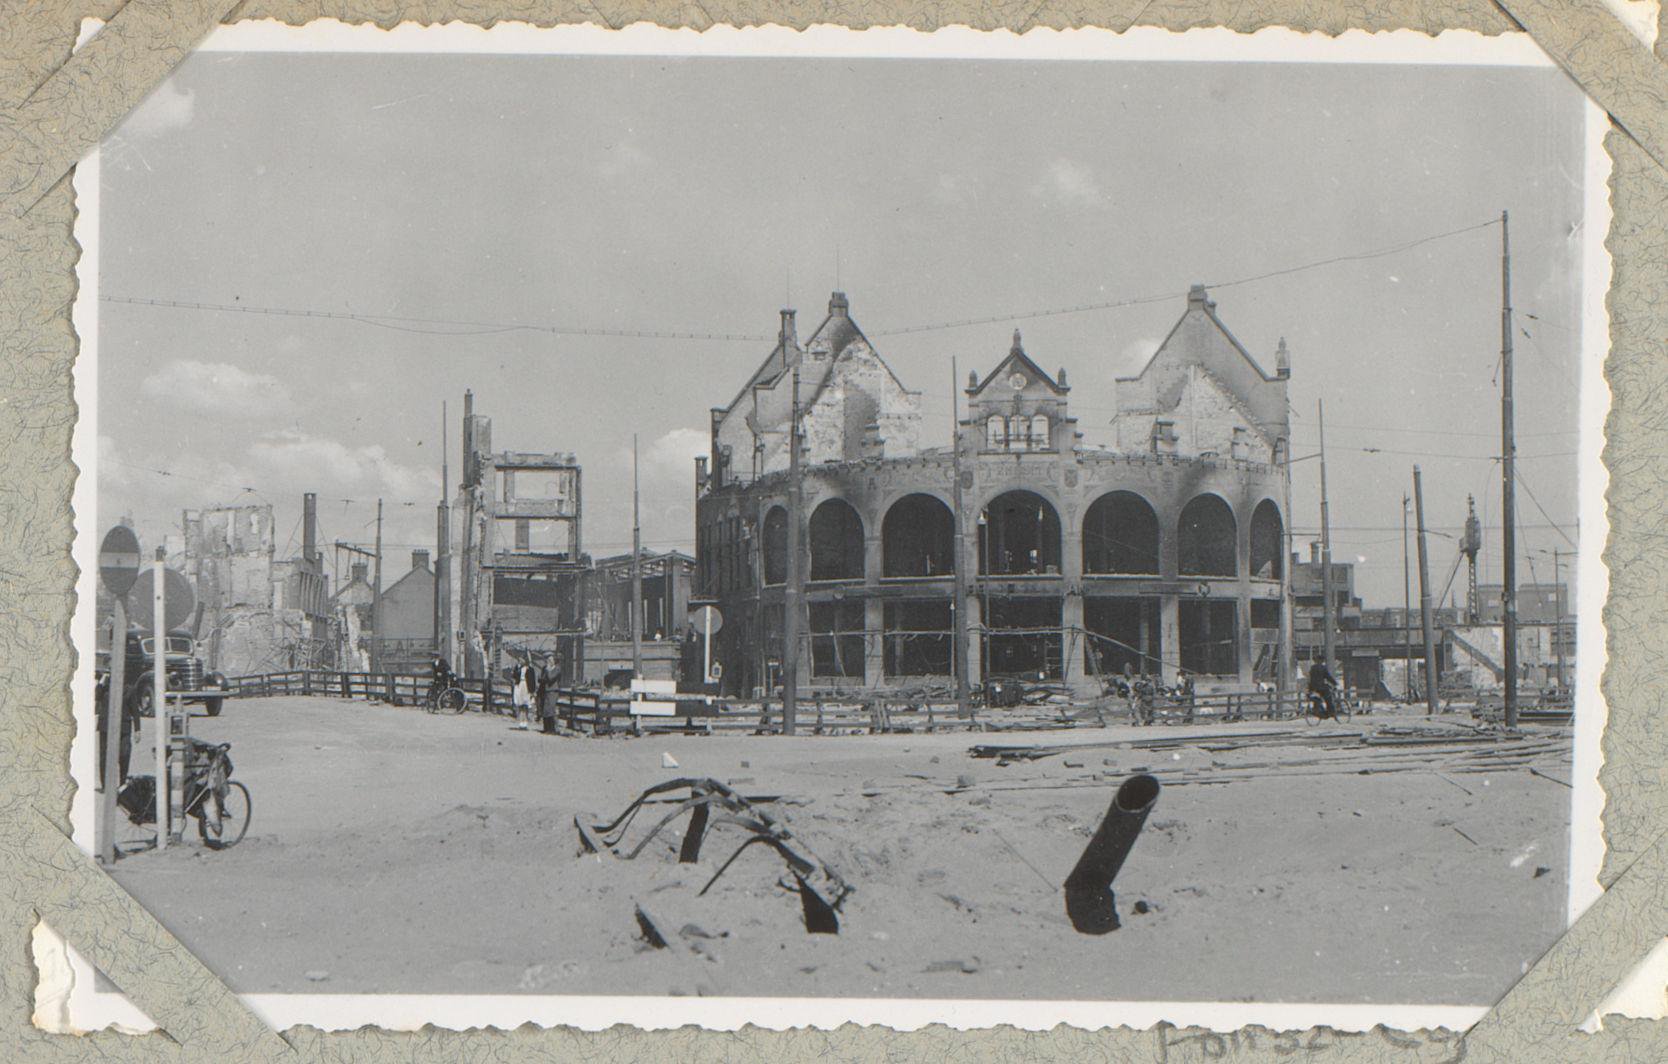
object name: photograph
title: Ruïnes aan het Hofplein te Rotterdam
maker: j. nolte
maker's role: fotograaf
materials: photographic support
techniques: gelatin silver print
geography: rotterdam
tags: devastated, ruined place or city (~ warfare), ruin of a dwelling, house, castle, etc., rotterdam, rotterdam blitz